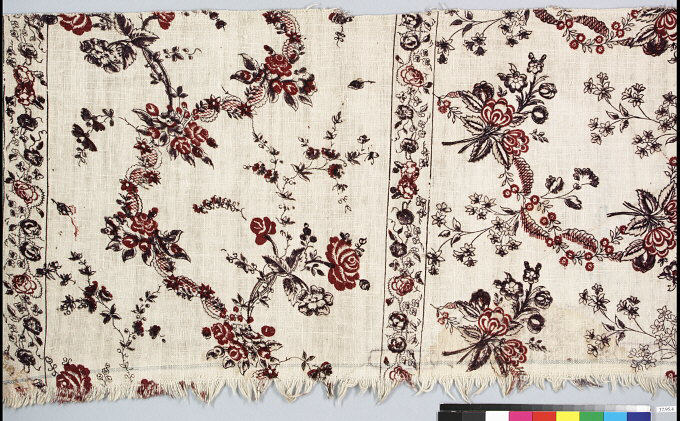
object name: piece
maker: miguel forment and co.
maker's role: manufactory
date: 1767-1800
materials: cotton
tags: flowers